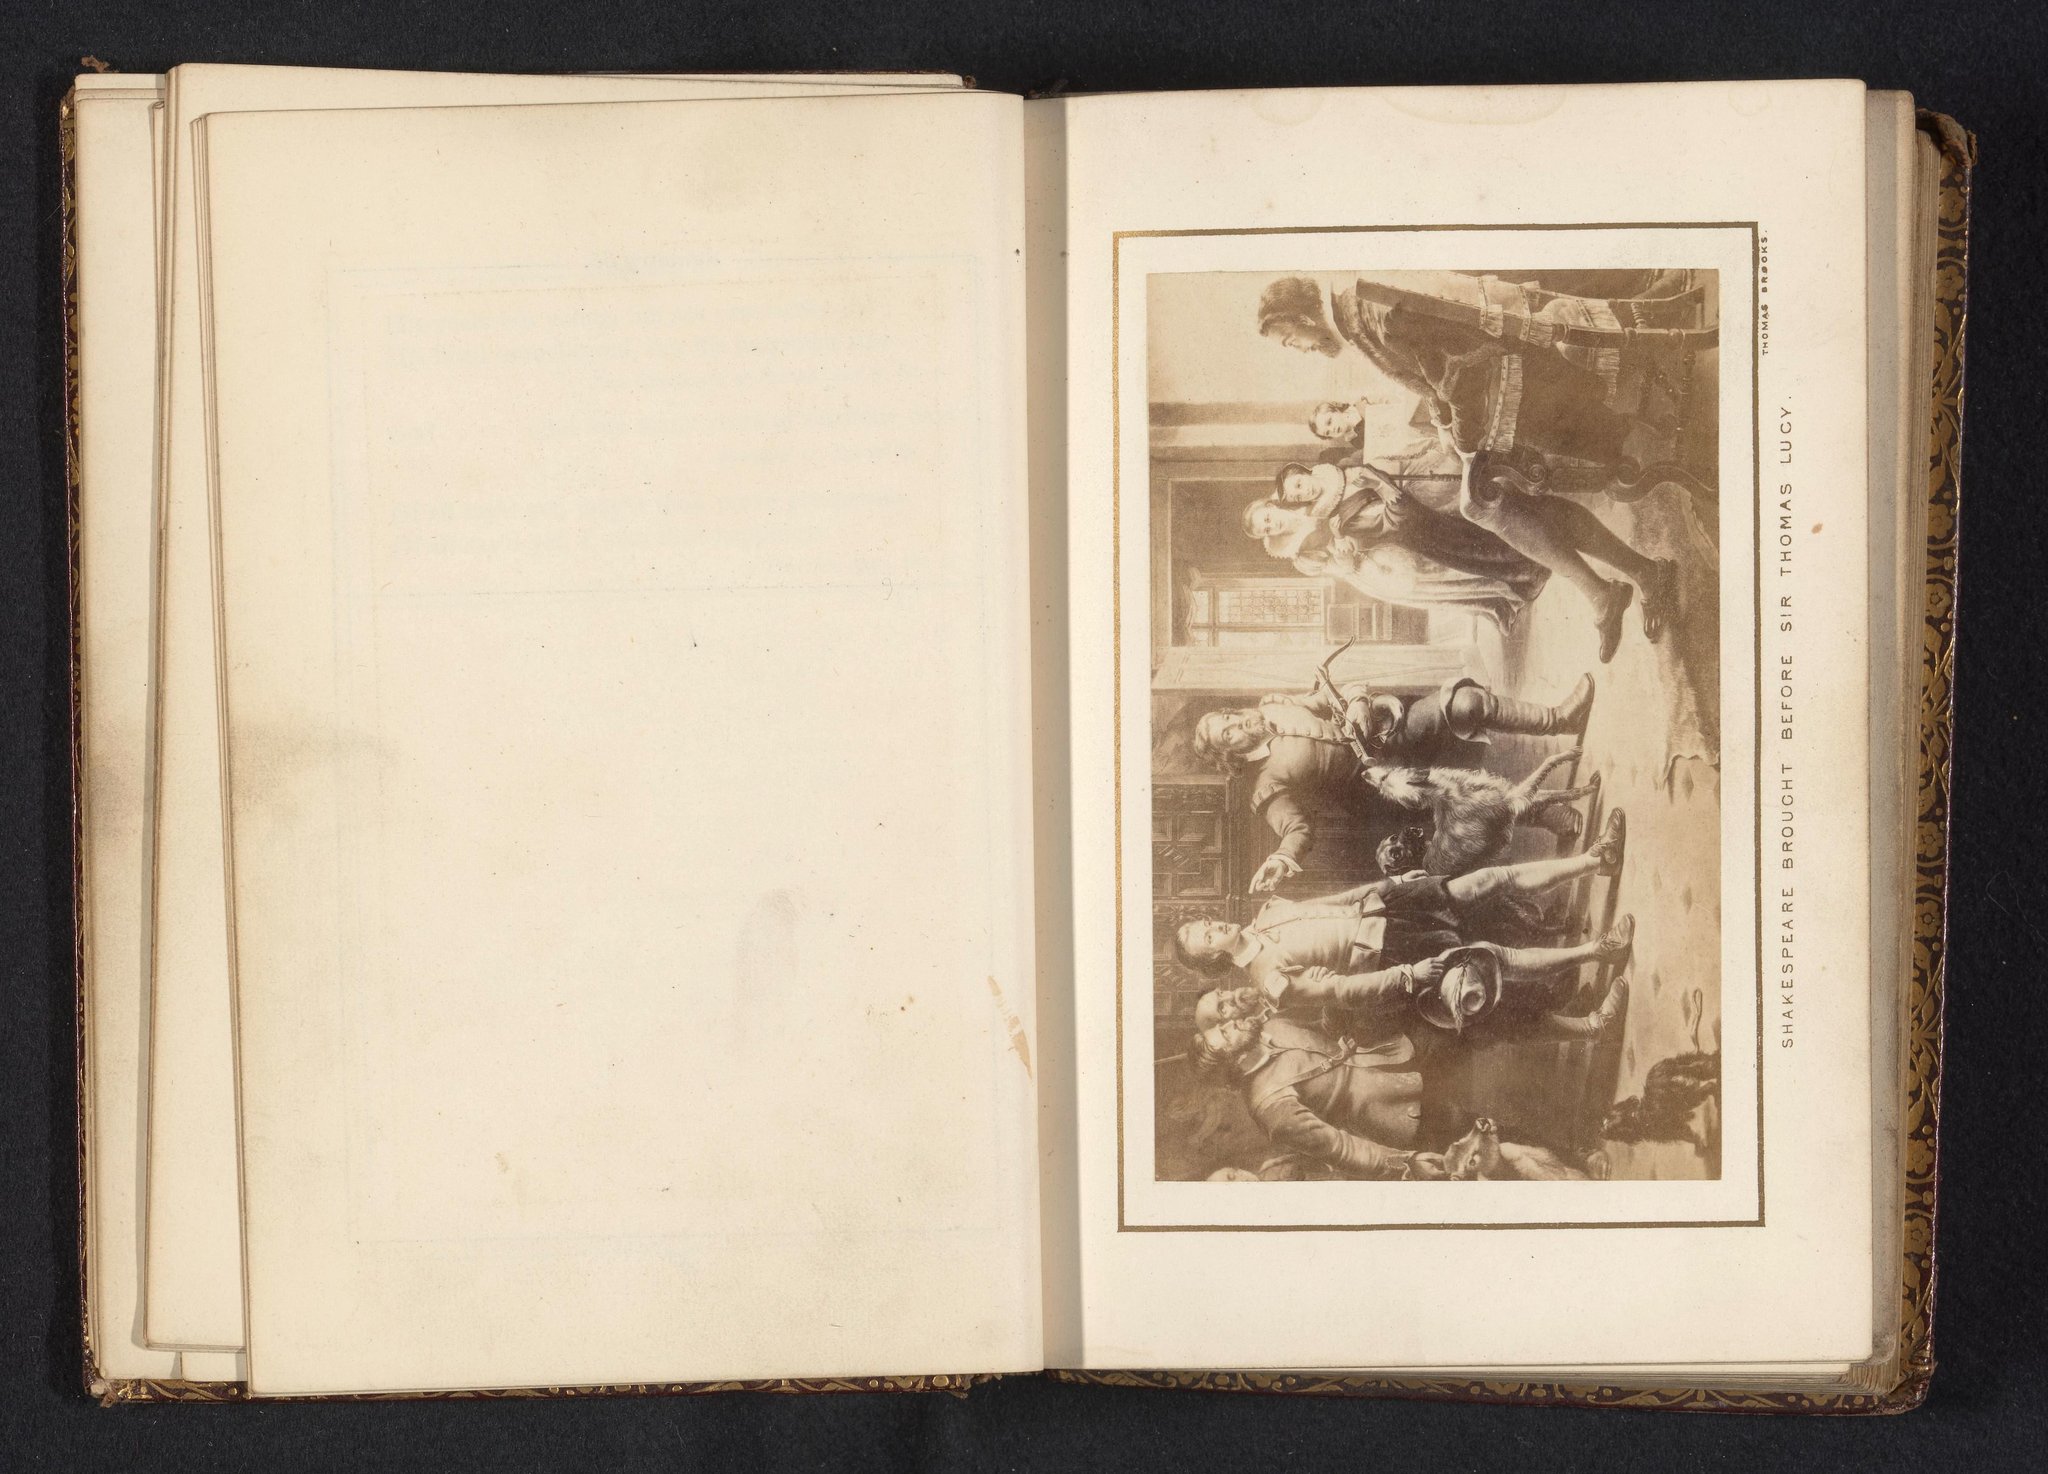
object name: photograph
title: Shakespeare brought before Sir Thomas Lucy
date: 1866-1876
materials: photographic support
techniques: albumen print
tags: william shakespeare, politician, e.g. party leader, writer, poet, author, interior ~ representation of a building